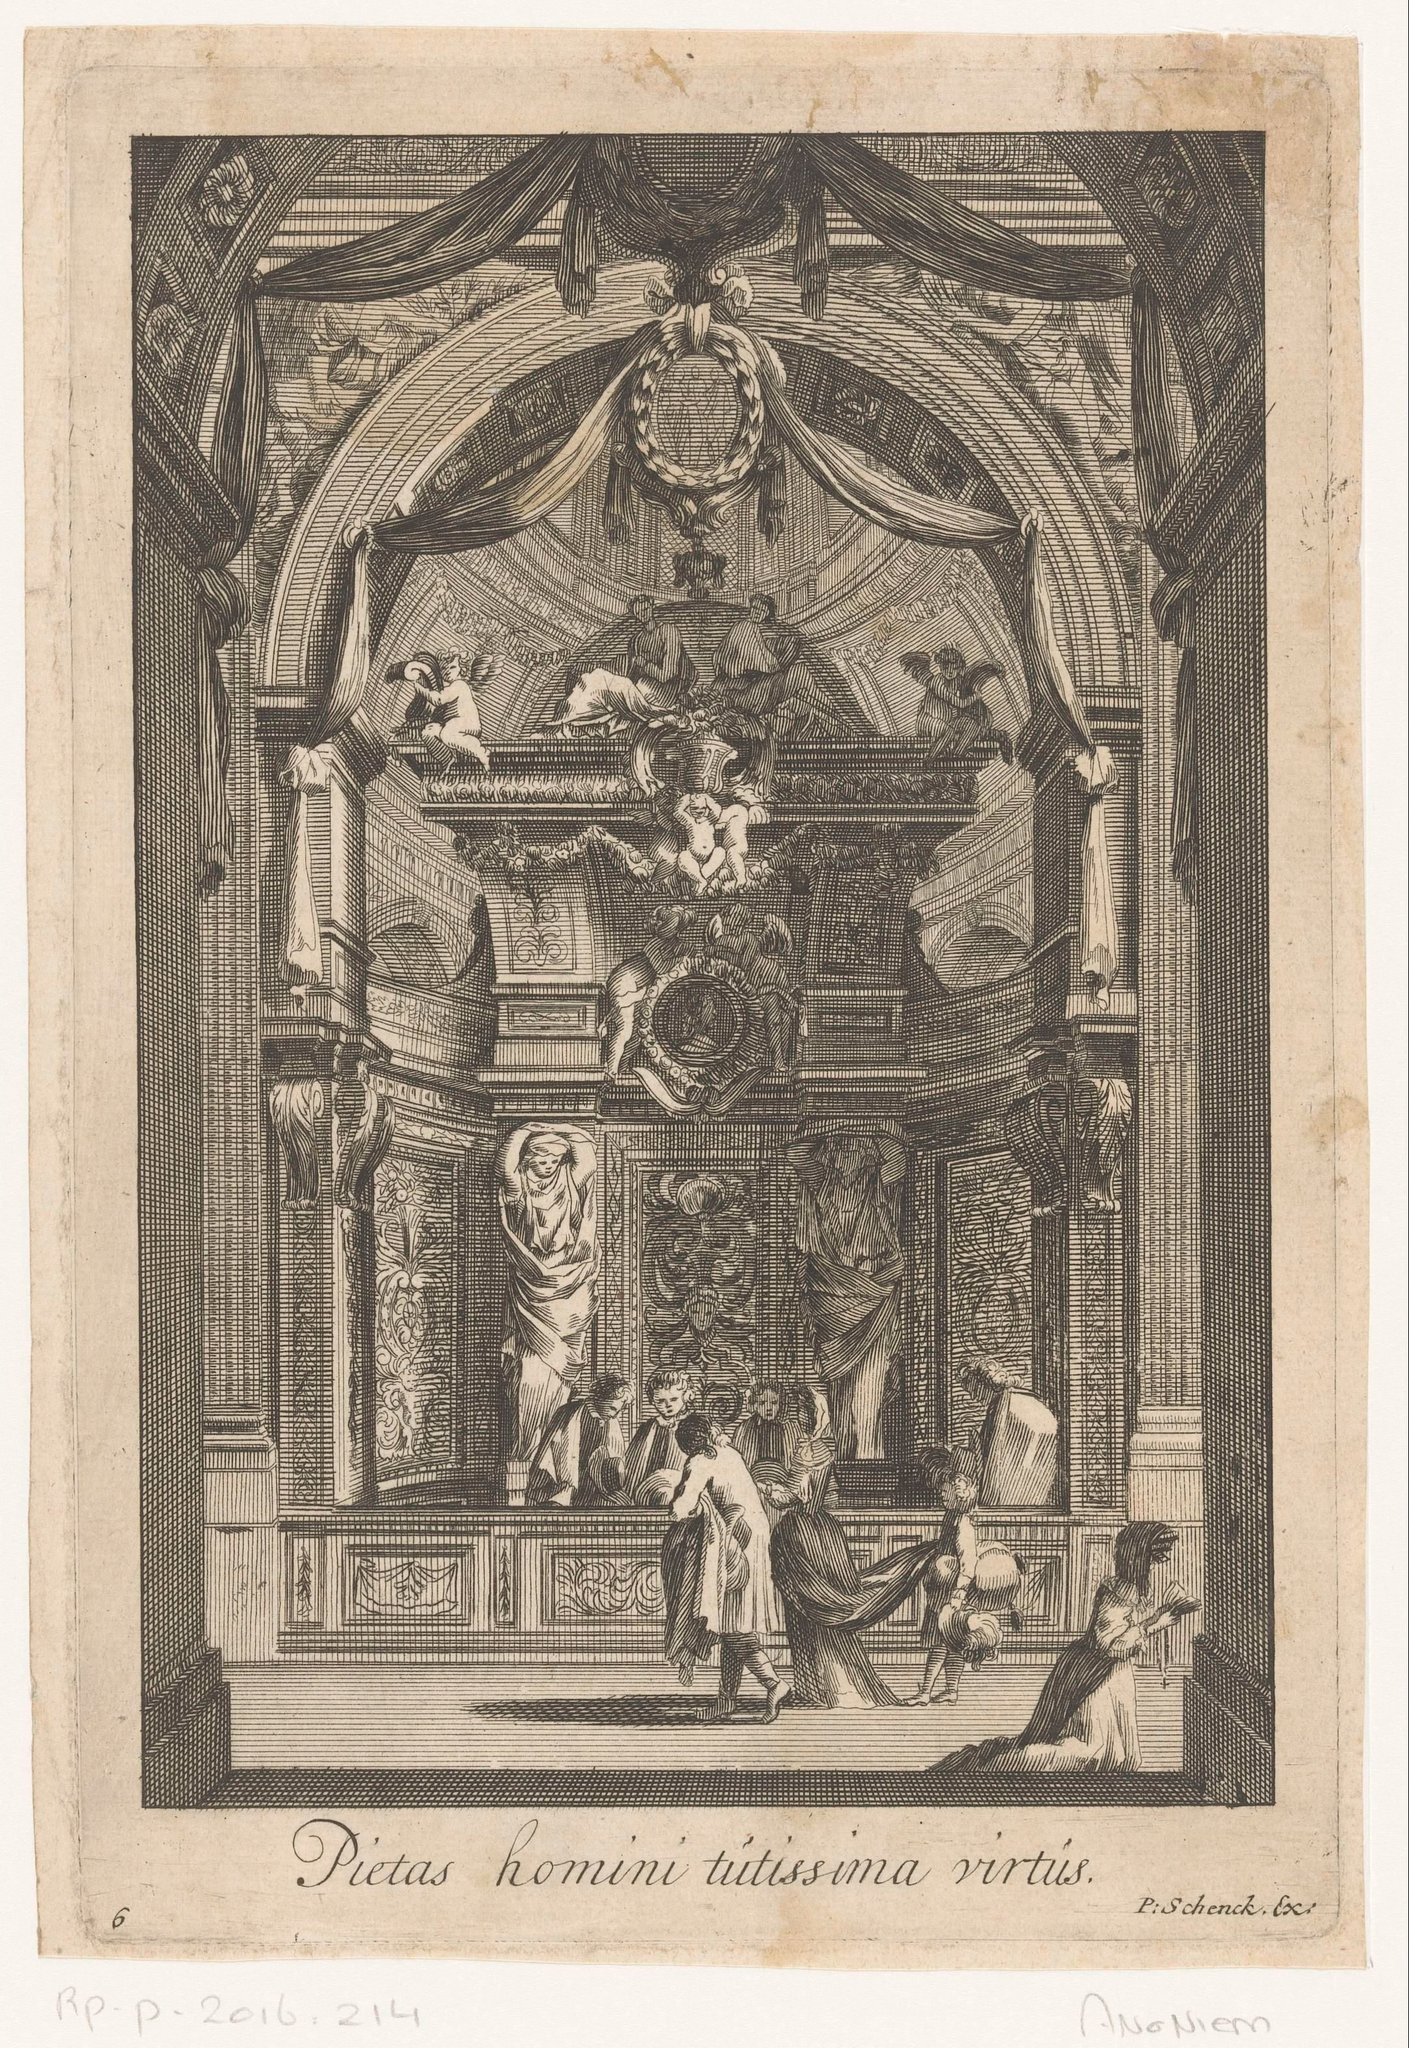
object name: ornament print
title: Verschillende mensen in een kapel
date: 1684-1711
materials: paper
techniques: engraving, etching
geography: amsterdam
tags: (public) prayer, parts of church interior: chapel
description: Een aantal gelovigen bidden, met de hoed in de handen, in een rijk versierde kapel. Een man en een vrouw lopen voorbij. Een jongen tilt de sleep van de vrouw.